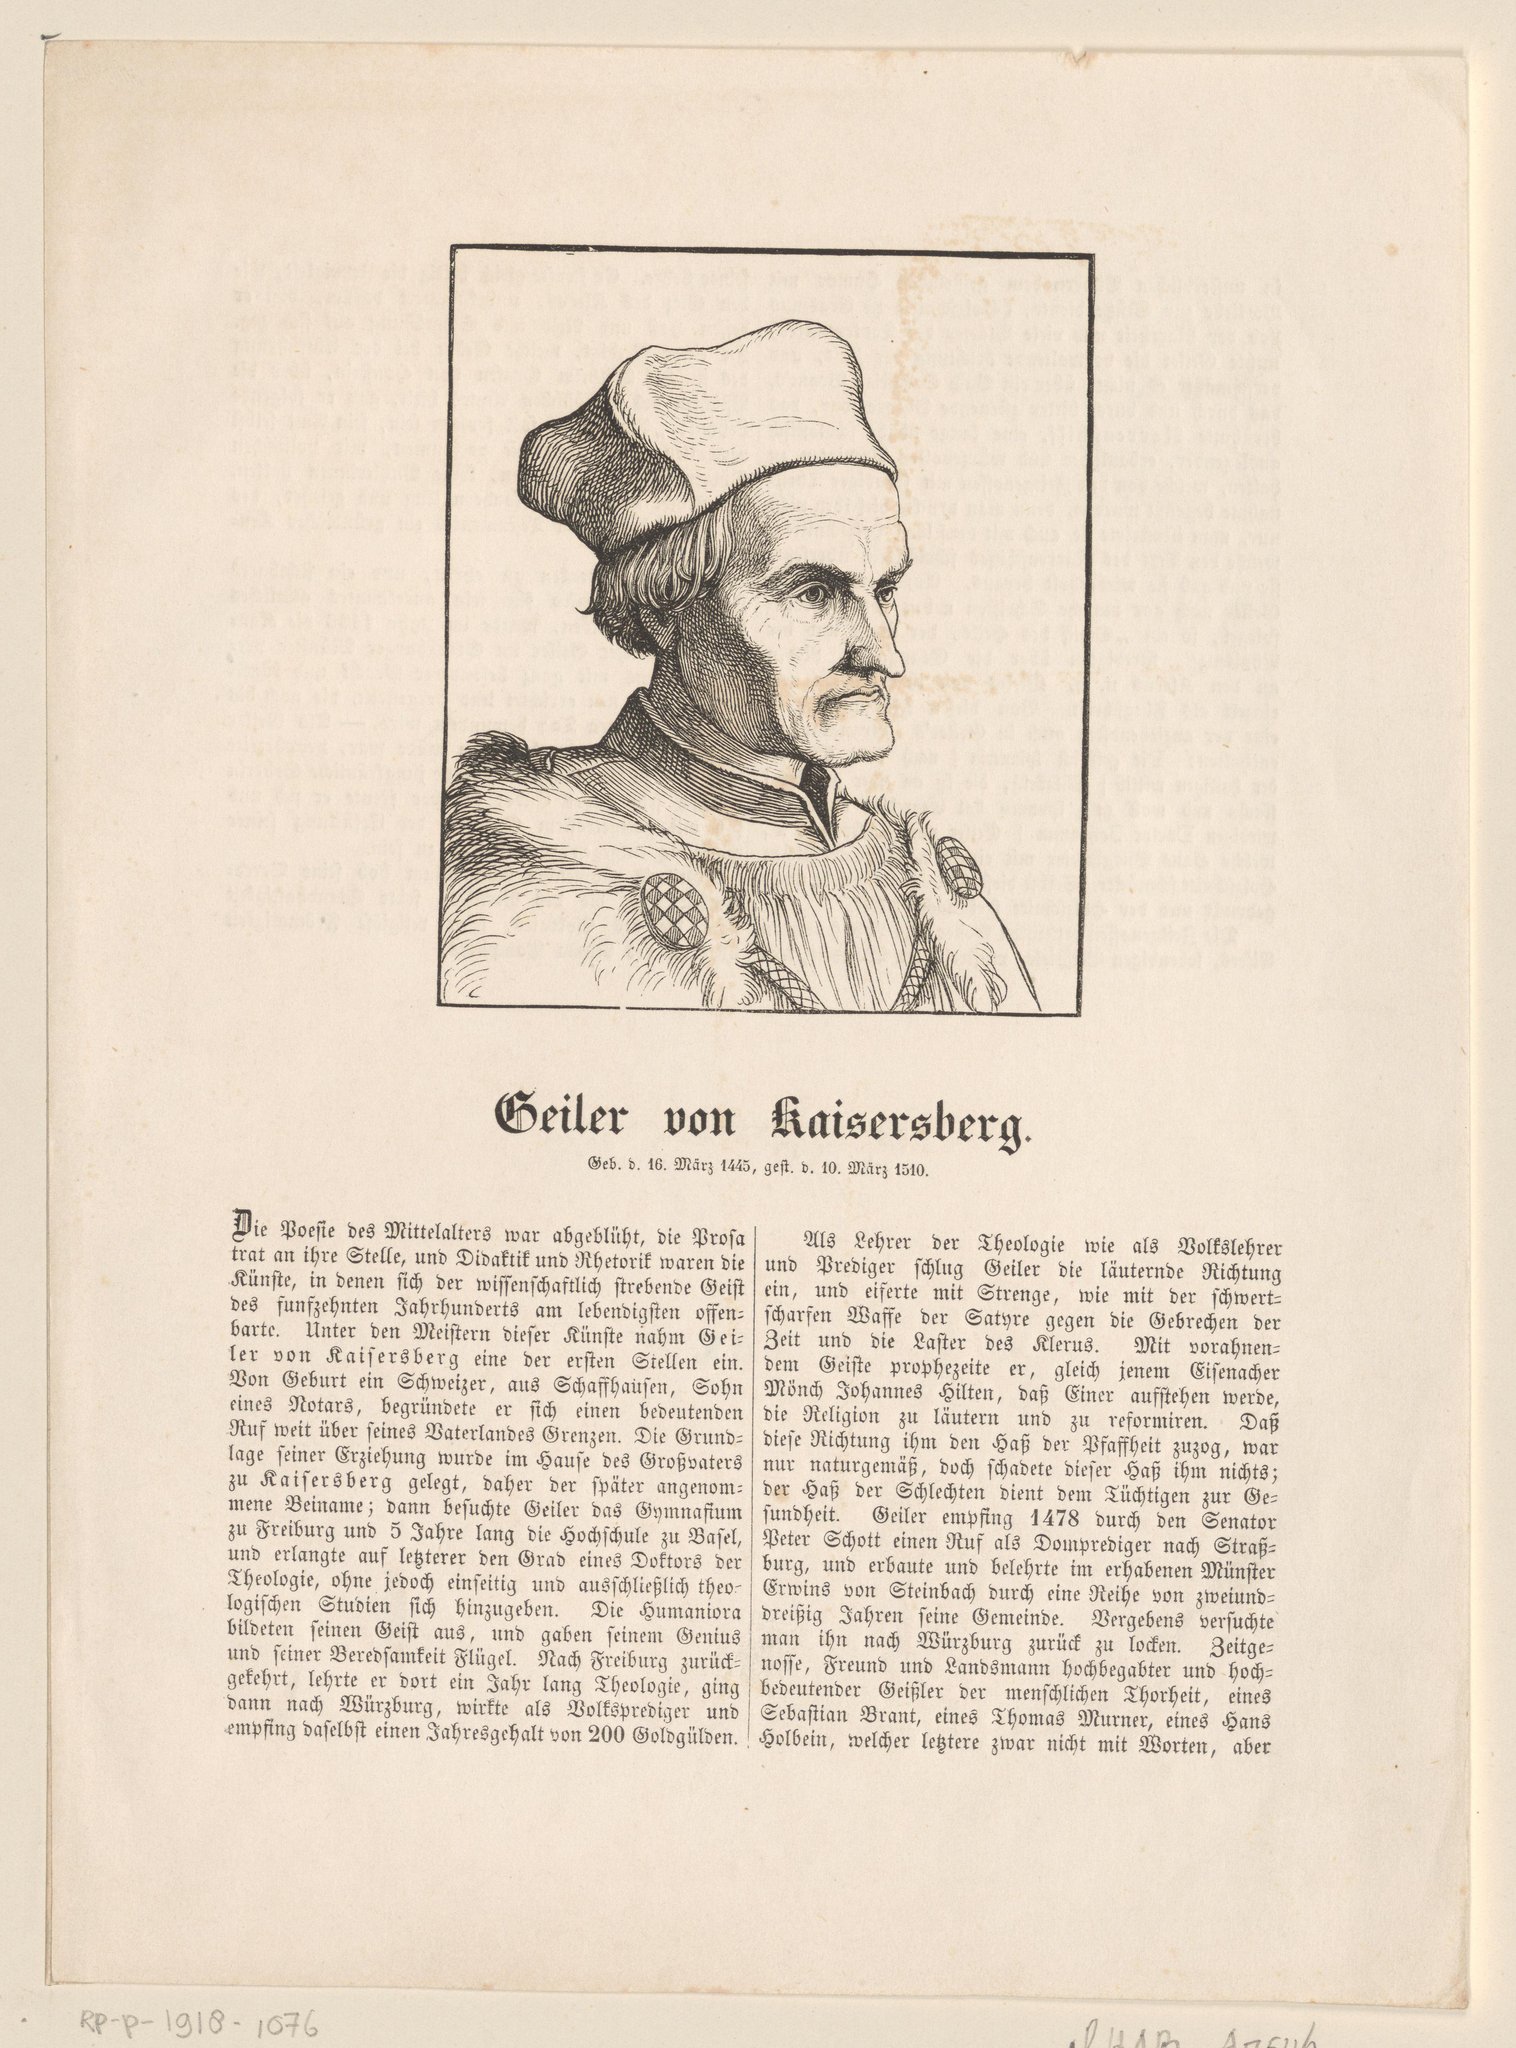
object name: print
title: Portret van Johannes Geiler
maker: Anonymous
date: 1750-1850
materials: paper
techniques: letterpress printing, engraving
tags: theologian, historical persons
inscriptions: collector's mark: Lugt 2233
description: Tekst in het Duits in de ondermarge en op het verso